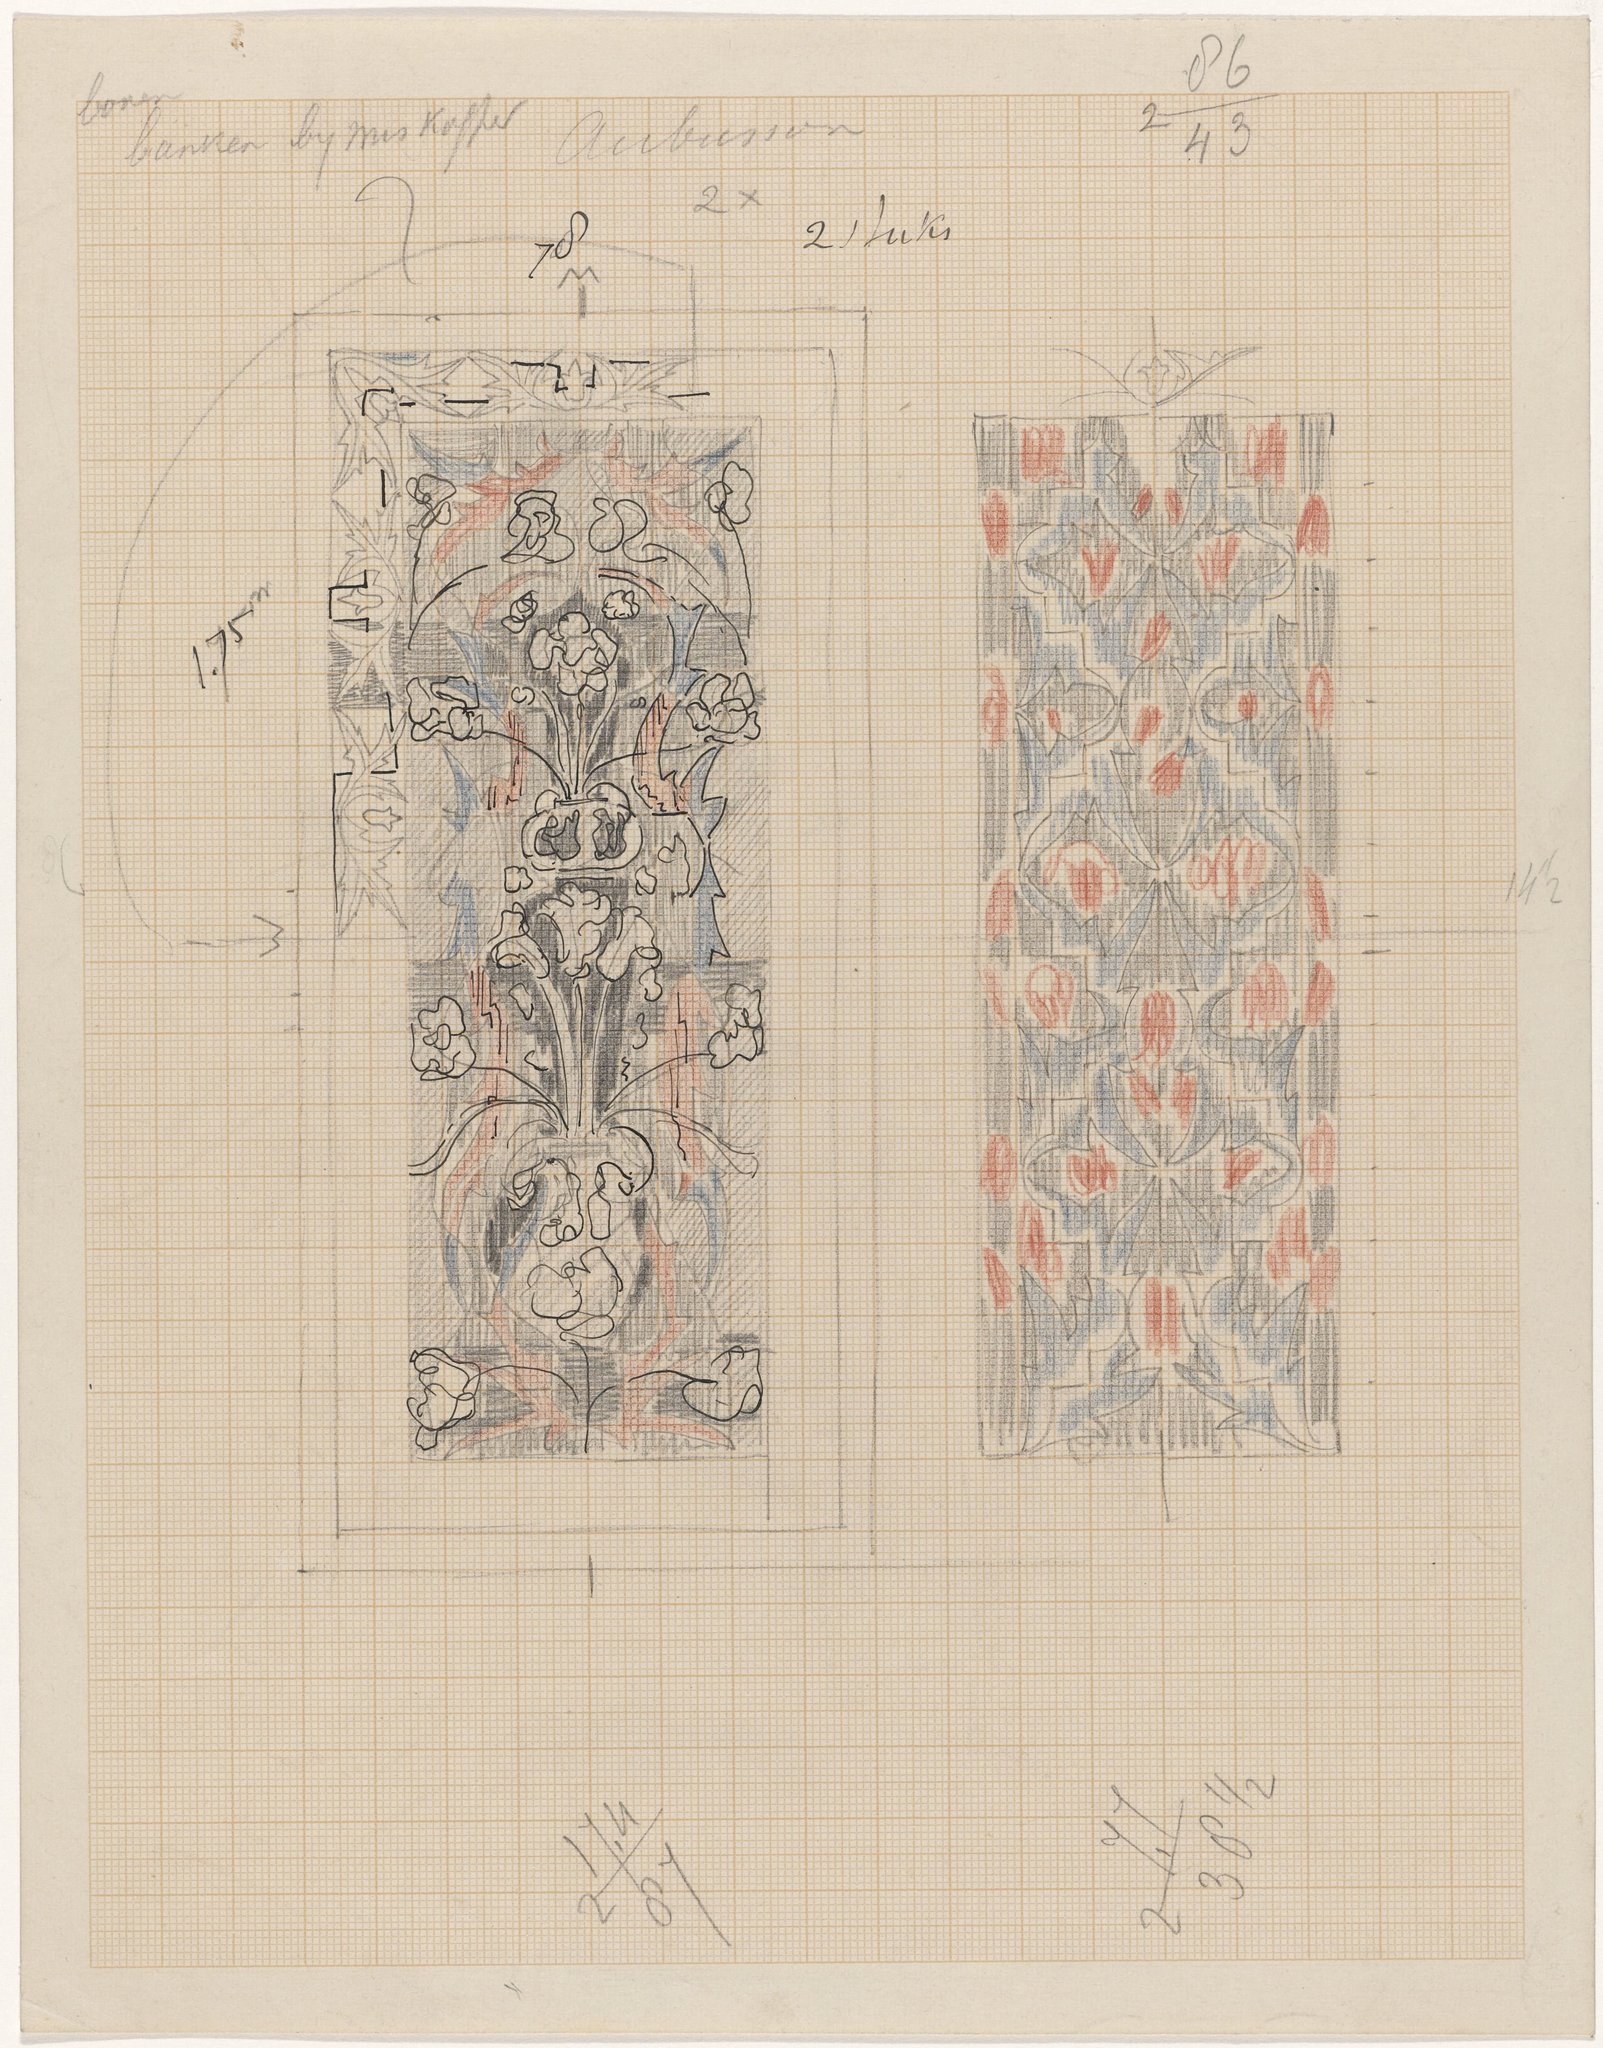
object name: design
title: Twee decoratieve ontwerpen met bloemenpatroon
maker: carel adolph lion cachet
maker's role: draughtsman, print maker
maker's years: 1864-1945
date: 1874-1945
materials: ink, pencil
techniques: pen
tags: flowers ~ ornament